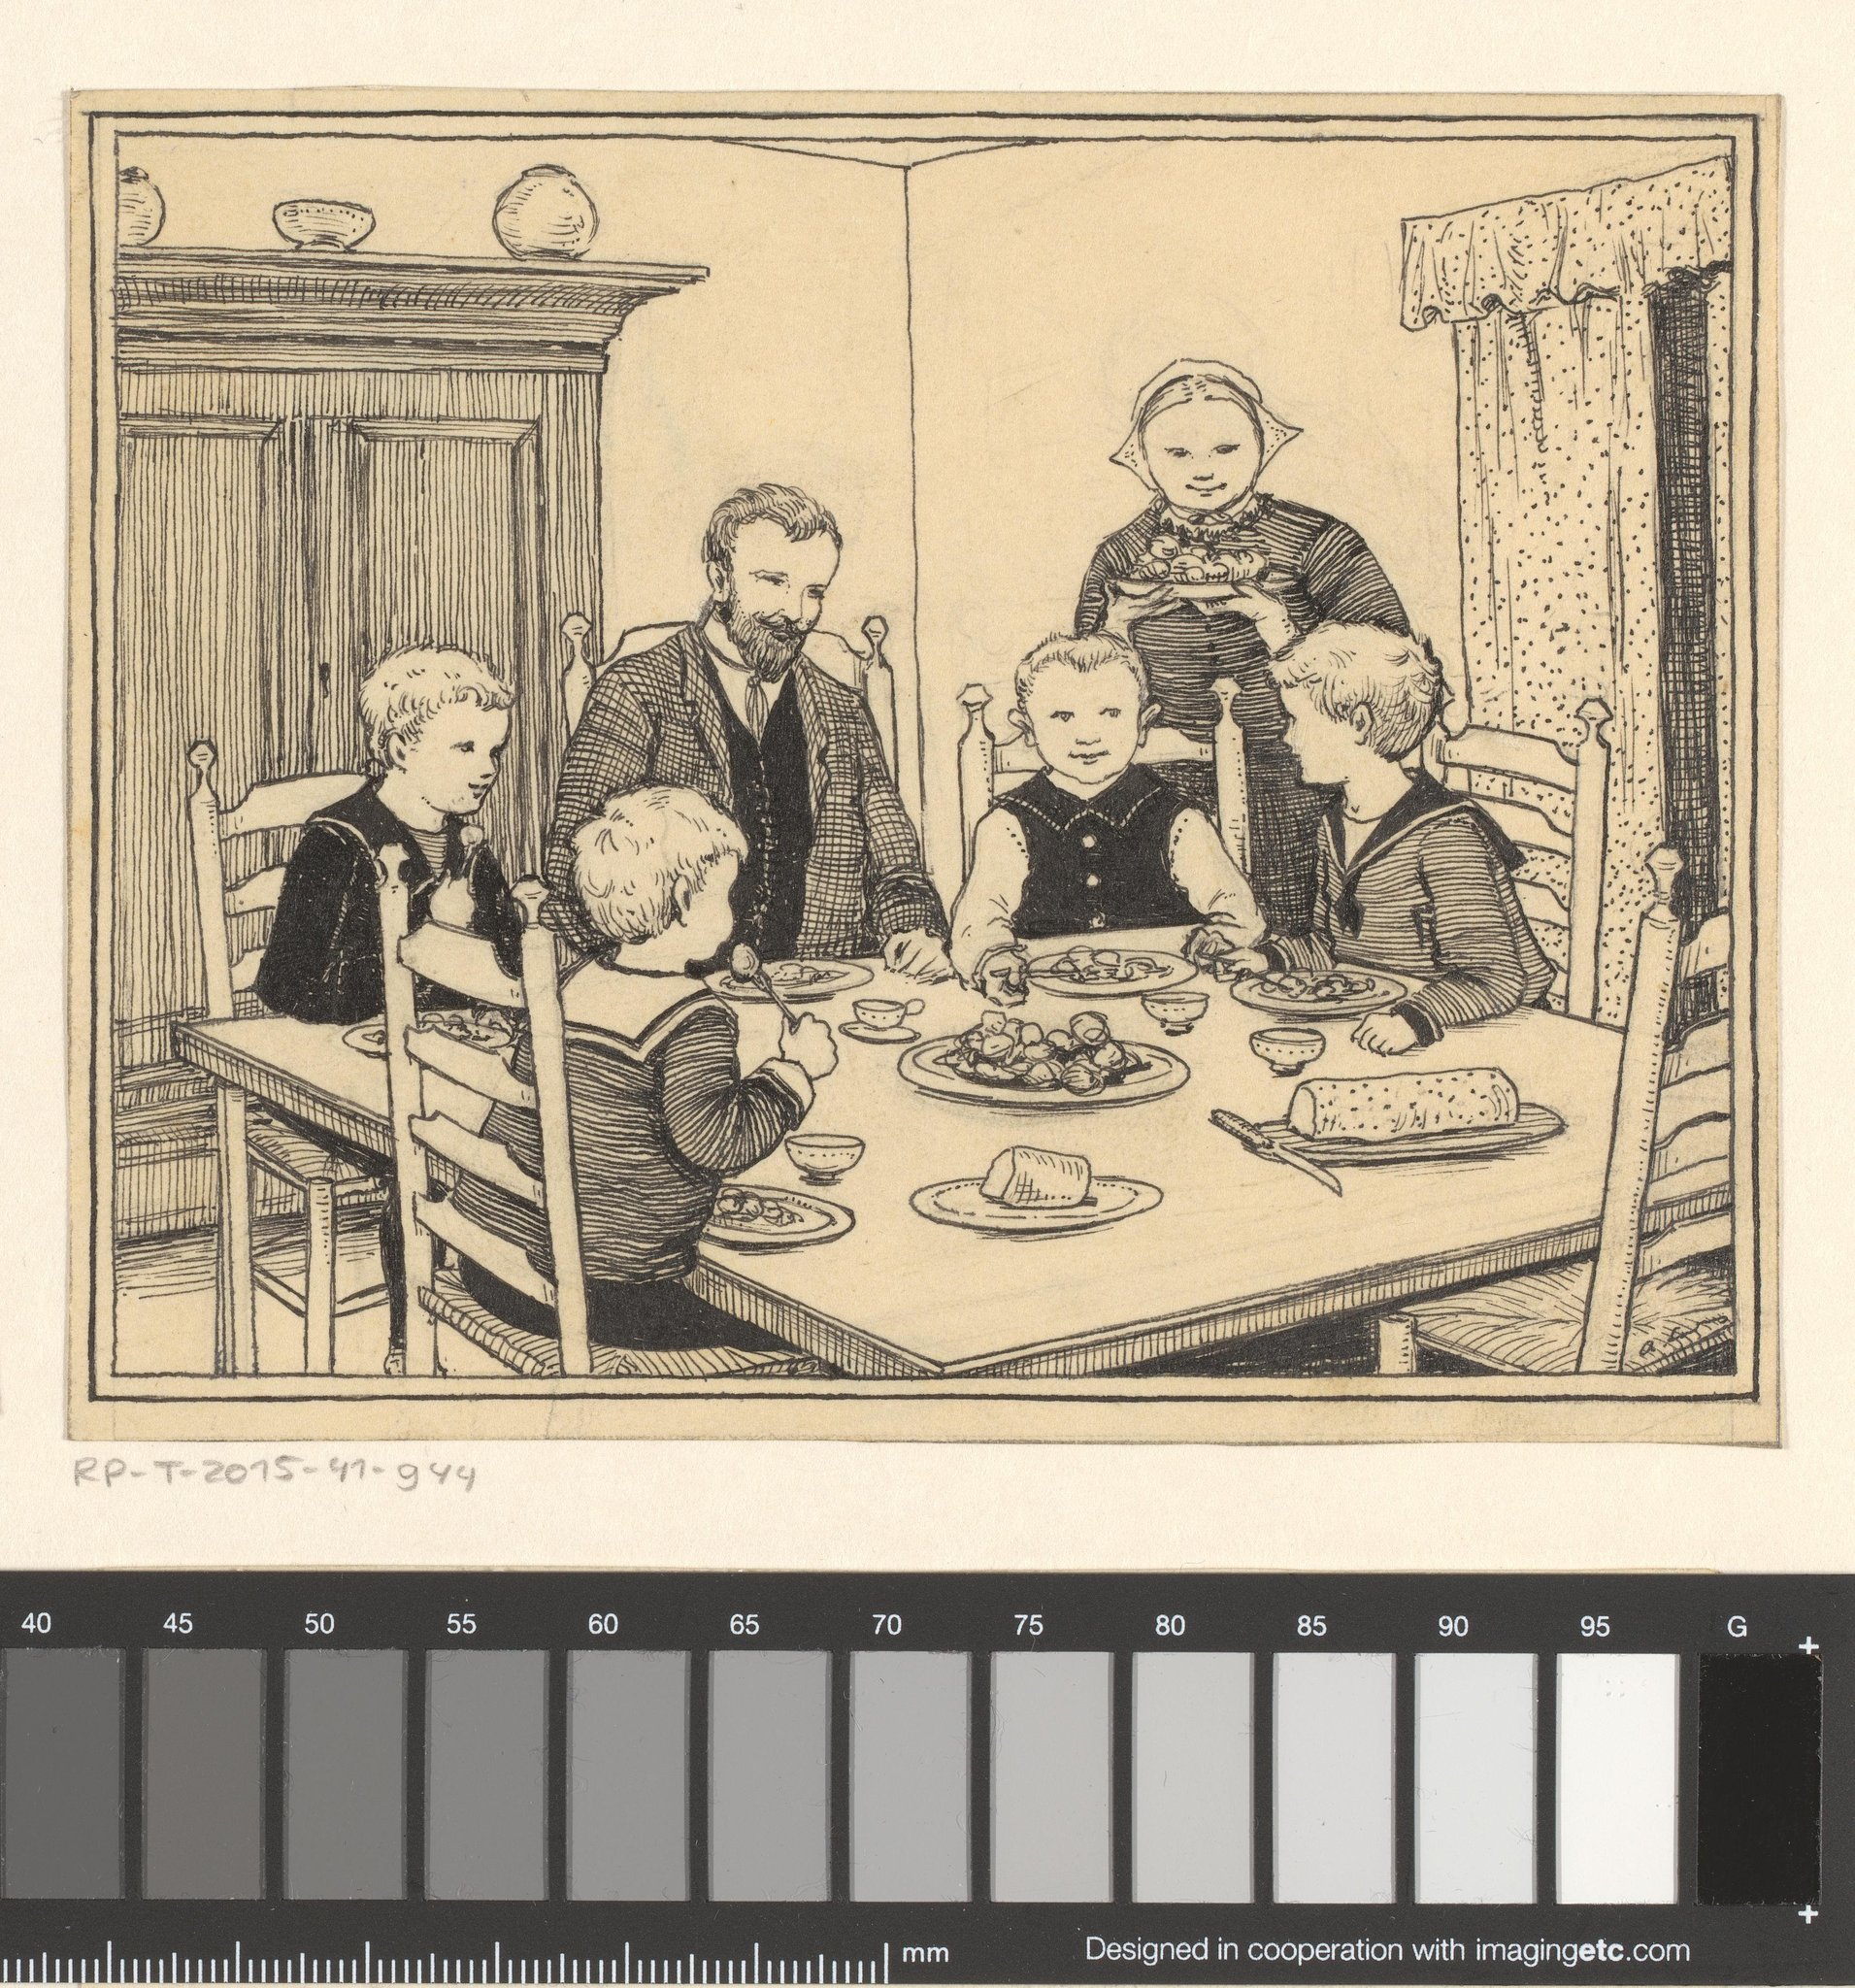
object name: drawing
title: Gezin aan de maaltijd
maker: adri ladenius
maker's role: draughtsman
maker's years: 1883-1953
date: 1916-1917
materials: ink, paper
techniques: pen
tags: laid table: table-ware, table-decoration, etc., (family) meal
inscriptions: annotation: ‘Het boertje’, collector's mark: Lugt 2228, :, signature: ‘A. Ladenius’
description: Een gezin bestaande uit een vader, moeder en vier kinderen zit aan een vierkante eettafel. Op tafel staan etenswaren uitgestald. Moeder staat bij de tafel met een schaal met eten.